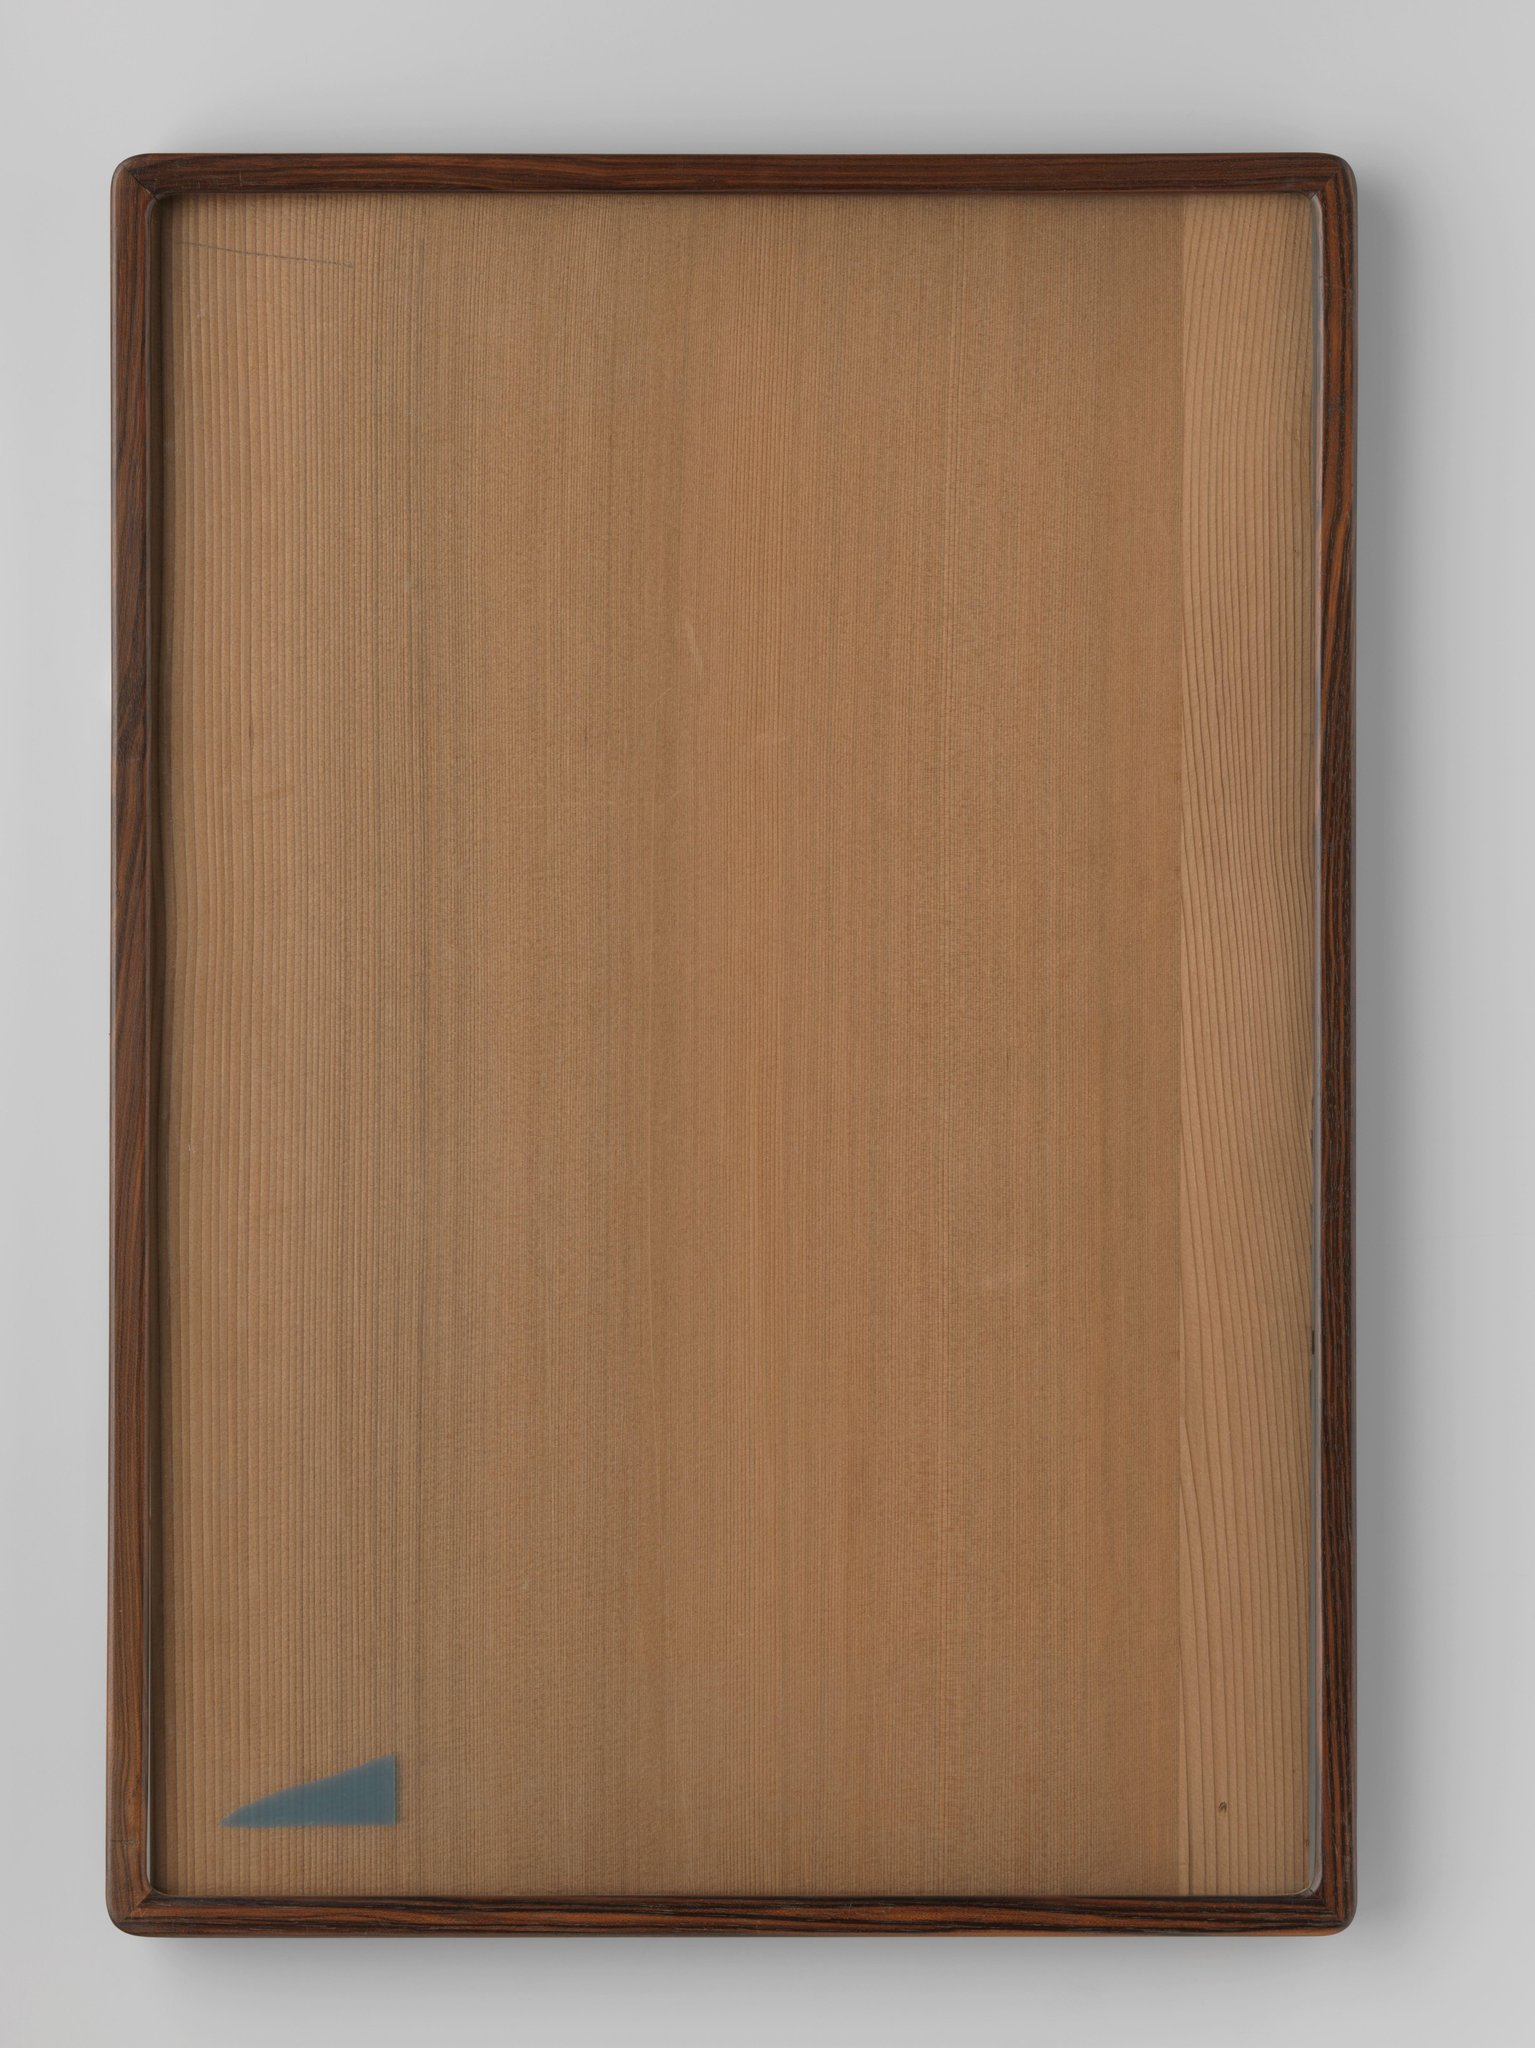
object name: frame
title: Smalle vlakke houten lijst horend bij een prent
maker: Anonymous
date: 1900-1925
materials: wood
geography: japan